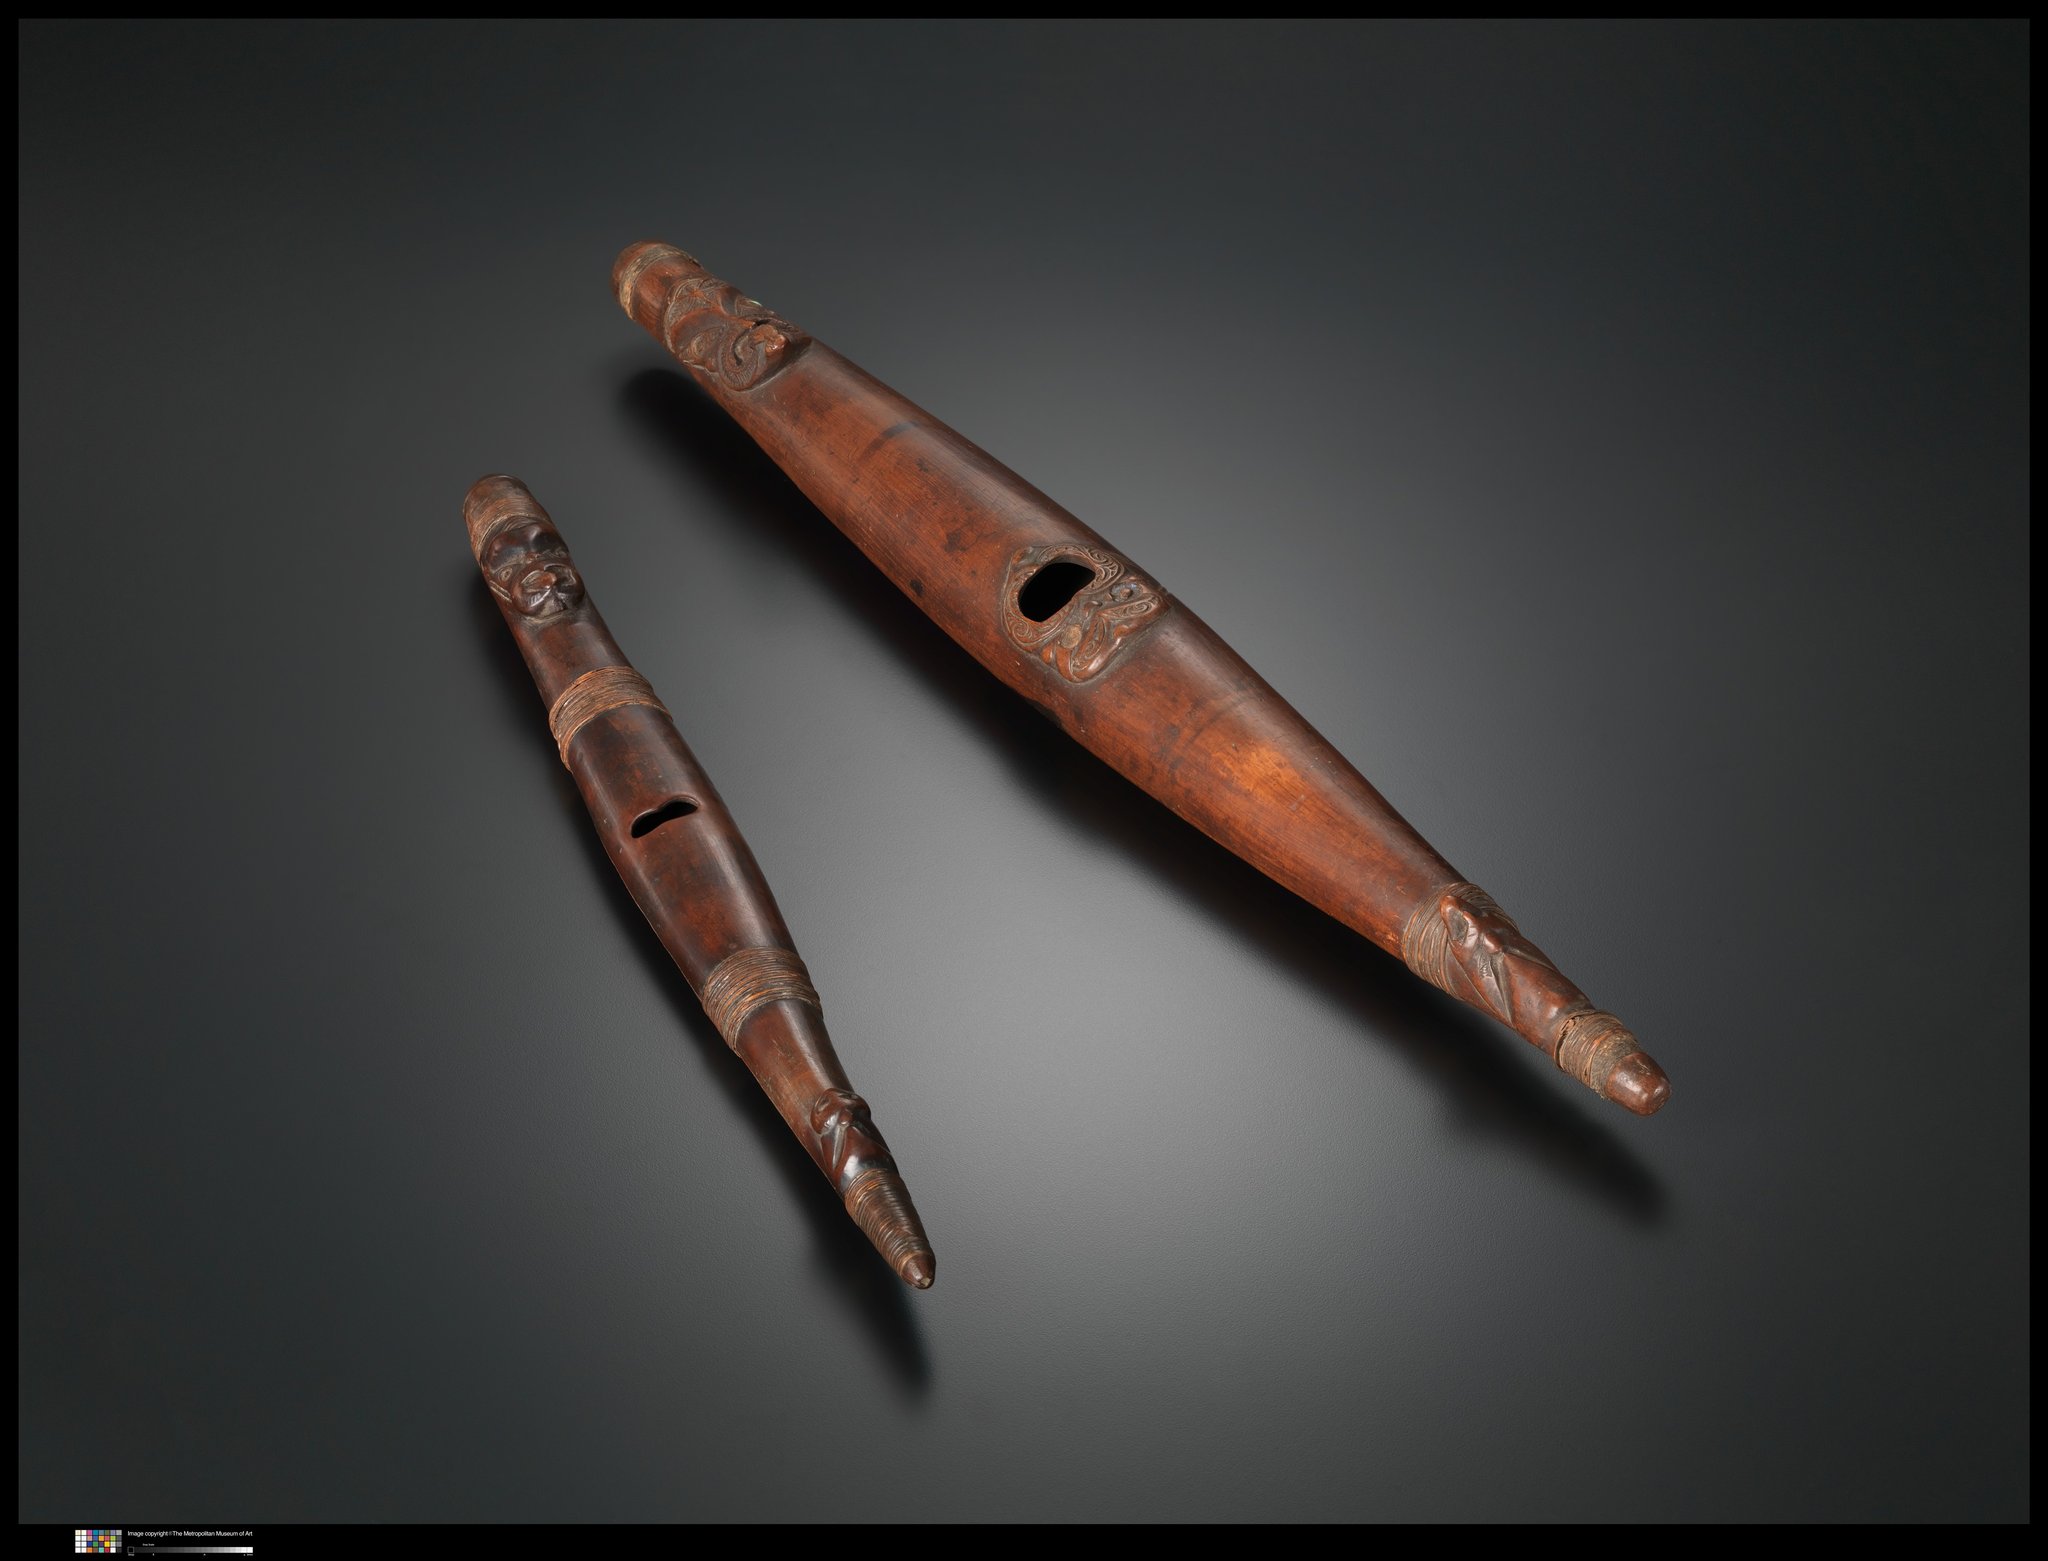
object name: pūtōrino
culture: maori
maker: maori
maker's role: culture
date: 1867-1900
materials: cord, fiber, shell, wood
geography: new zealand